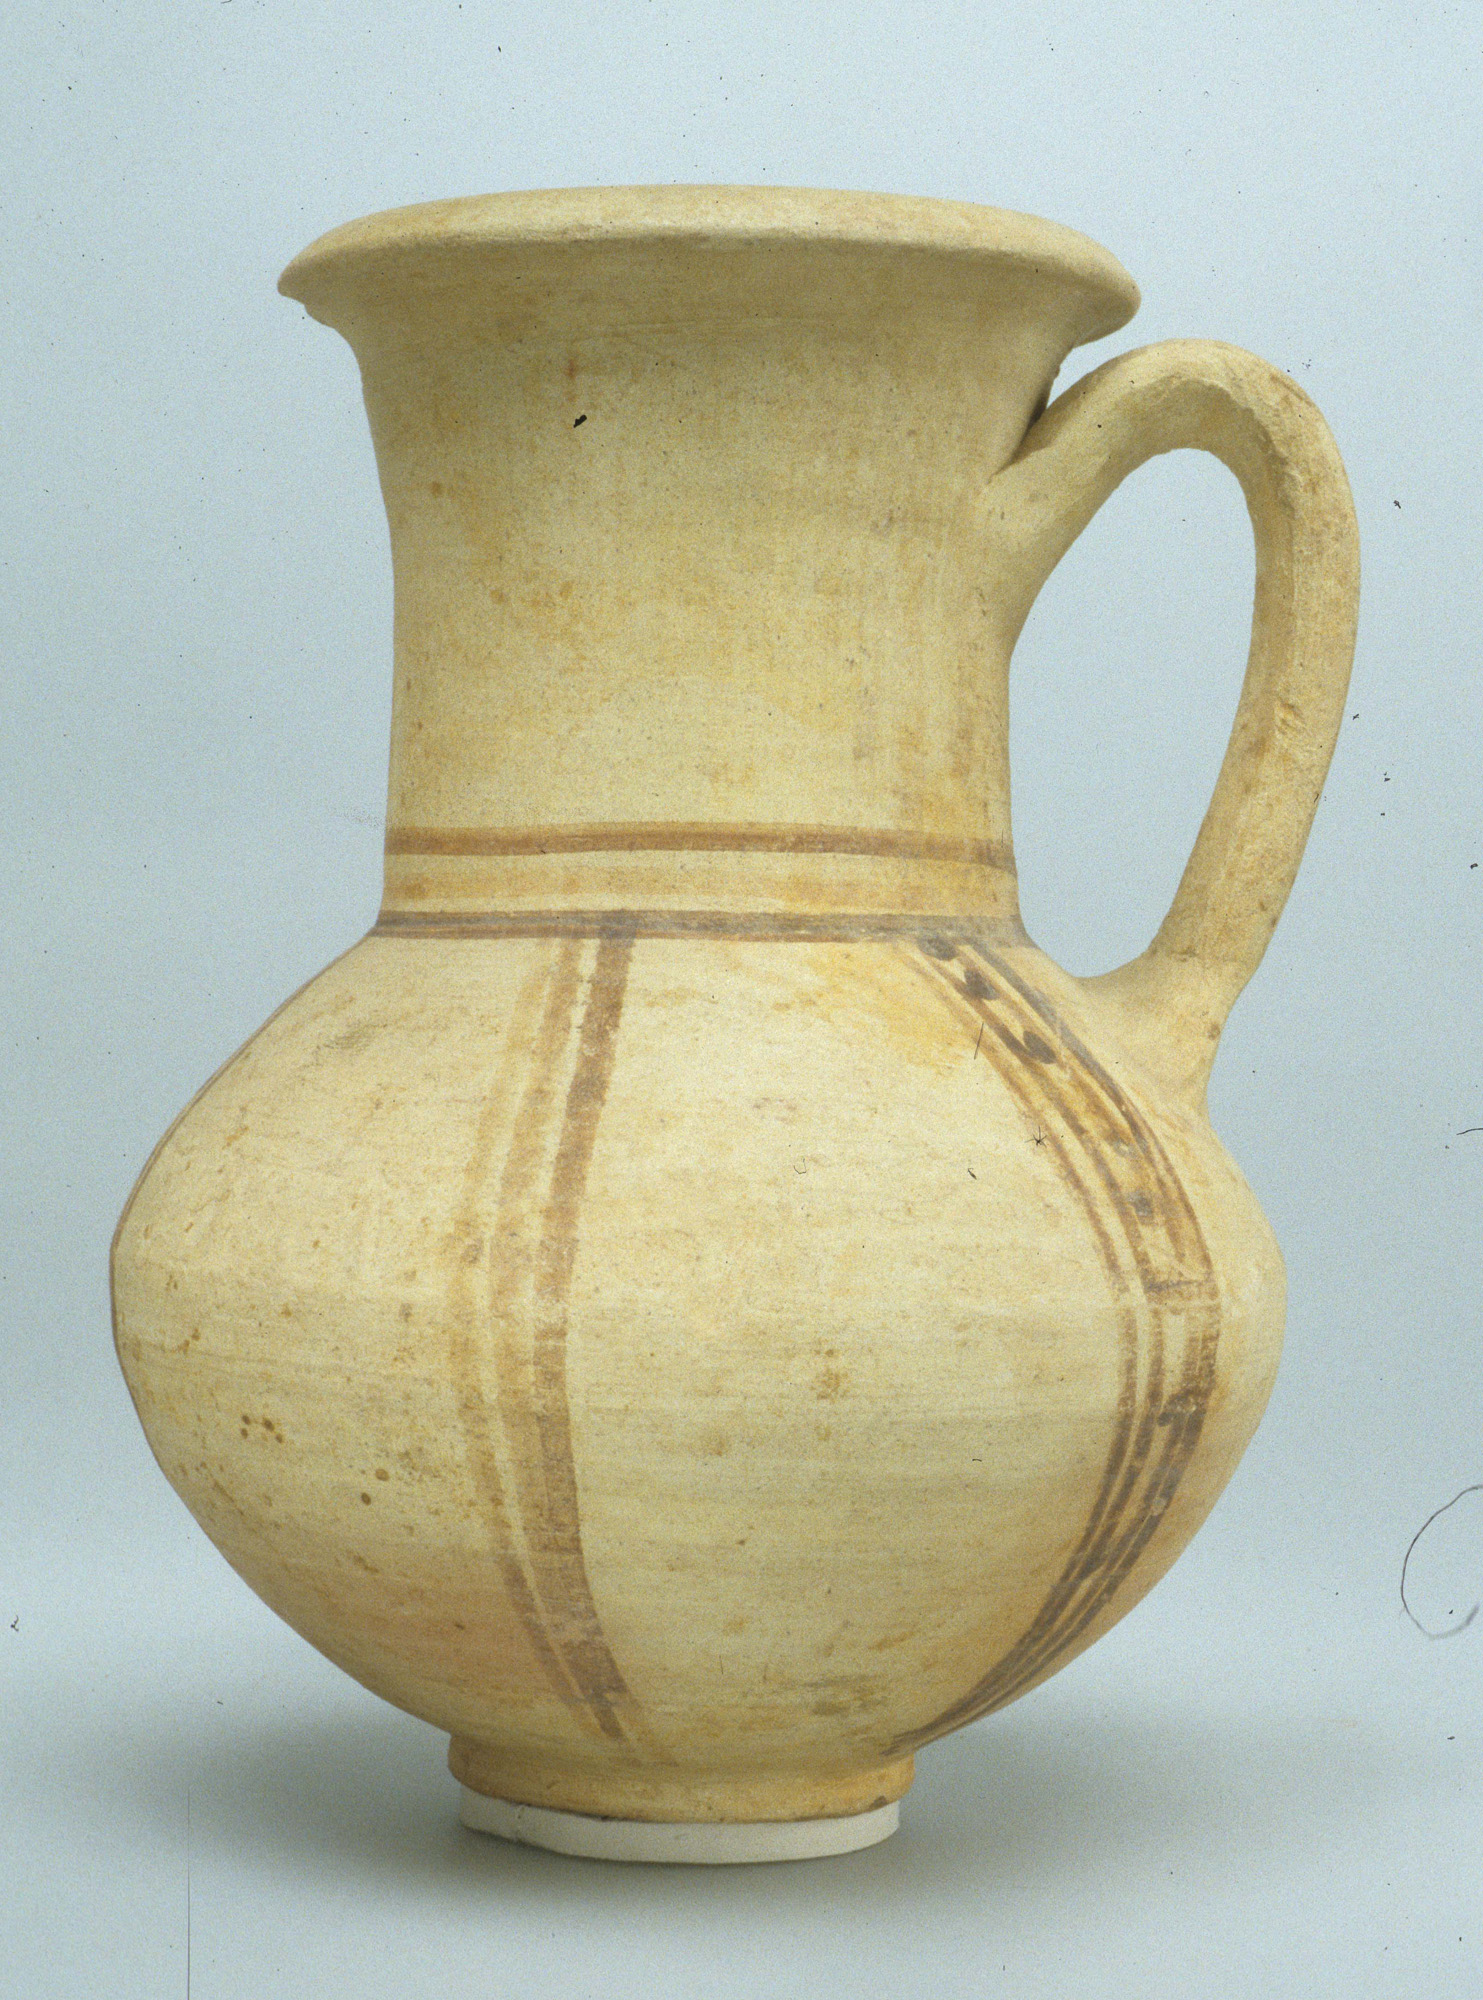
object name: vase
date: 1550-1295 BCE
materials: pottery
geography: egypt